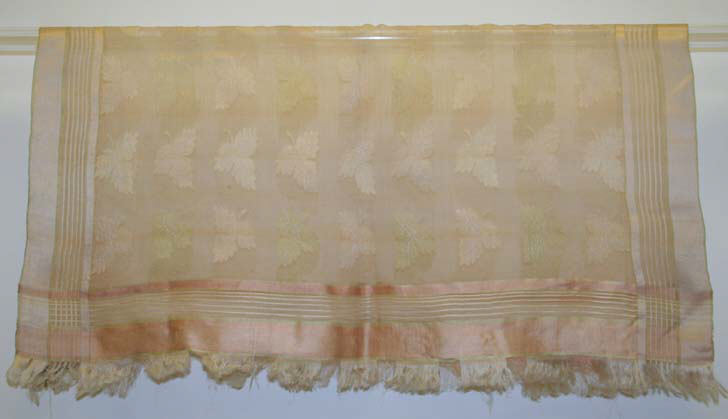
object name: shawl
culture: american or european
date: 1804-1814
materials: silk